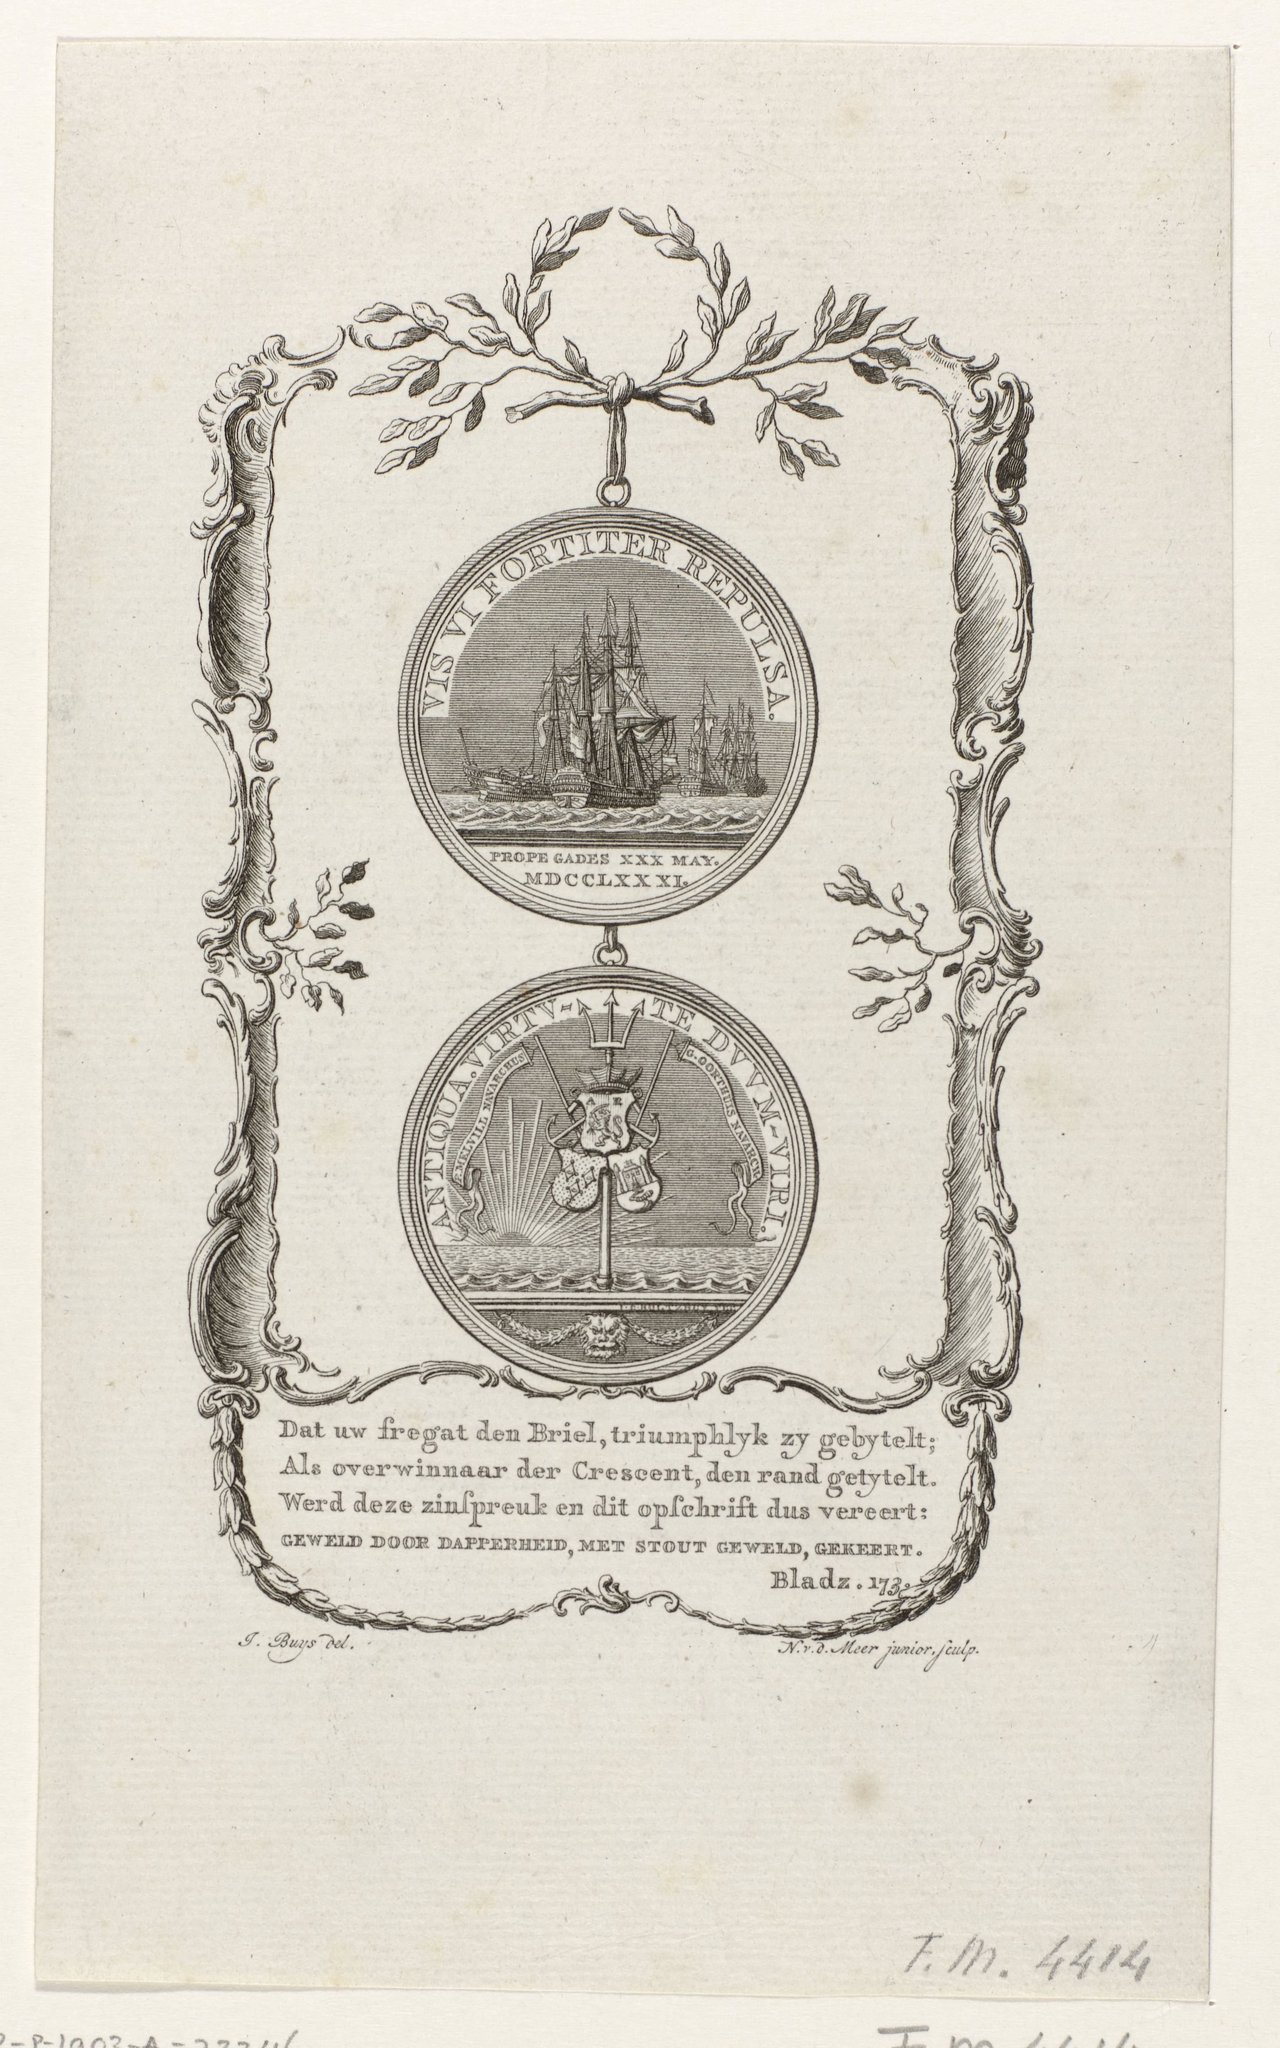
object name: print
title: Penning ter ere van Gerardus Oorthuys, kapitein van het fregat Den Briel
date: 1781-1782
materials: paper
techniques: engraving, etching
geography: northern netherlands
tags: rotterdam, gerardus oorthuys, battle (+ naval force), medal (considered as a piece of sculpture, regardless of its specific function)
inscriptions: collector's mark: Lugt 2228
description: Penning geslagen ter ere van Gerardus Oorthuys, kapitein van het fregat Den Briel, die zijn Engelse tegenstander, het fregat Crescent, overwon tijdens de zeeslag bij Cadiz op 30 mei 1781. Voor- en keerzijde van de penning binnen een ornamentale omlijsting. Onderaan een vierregelig vers en een verwijzing naar blz. 173.